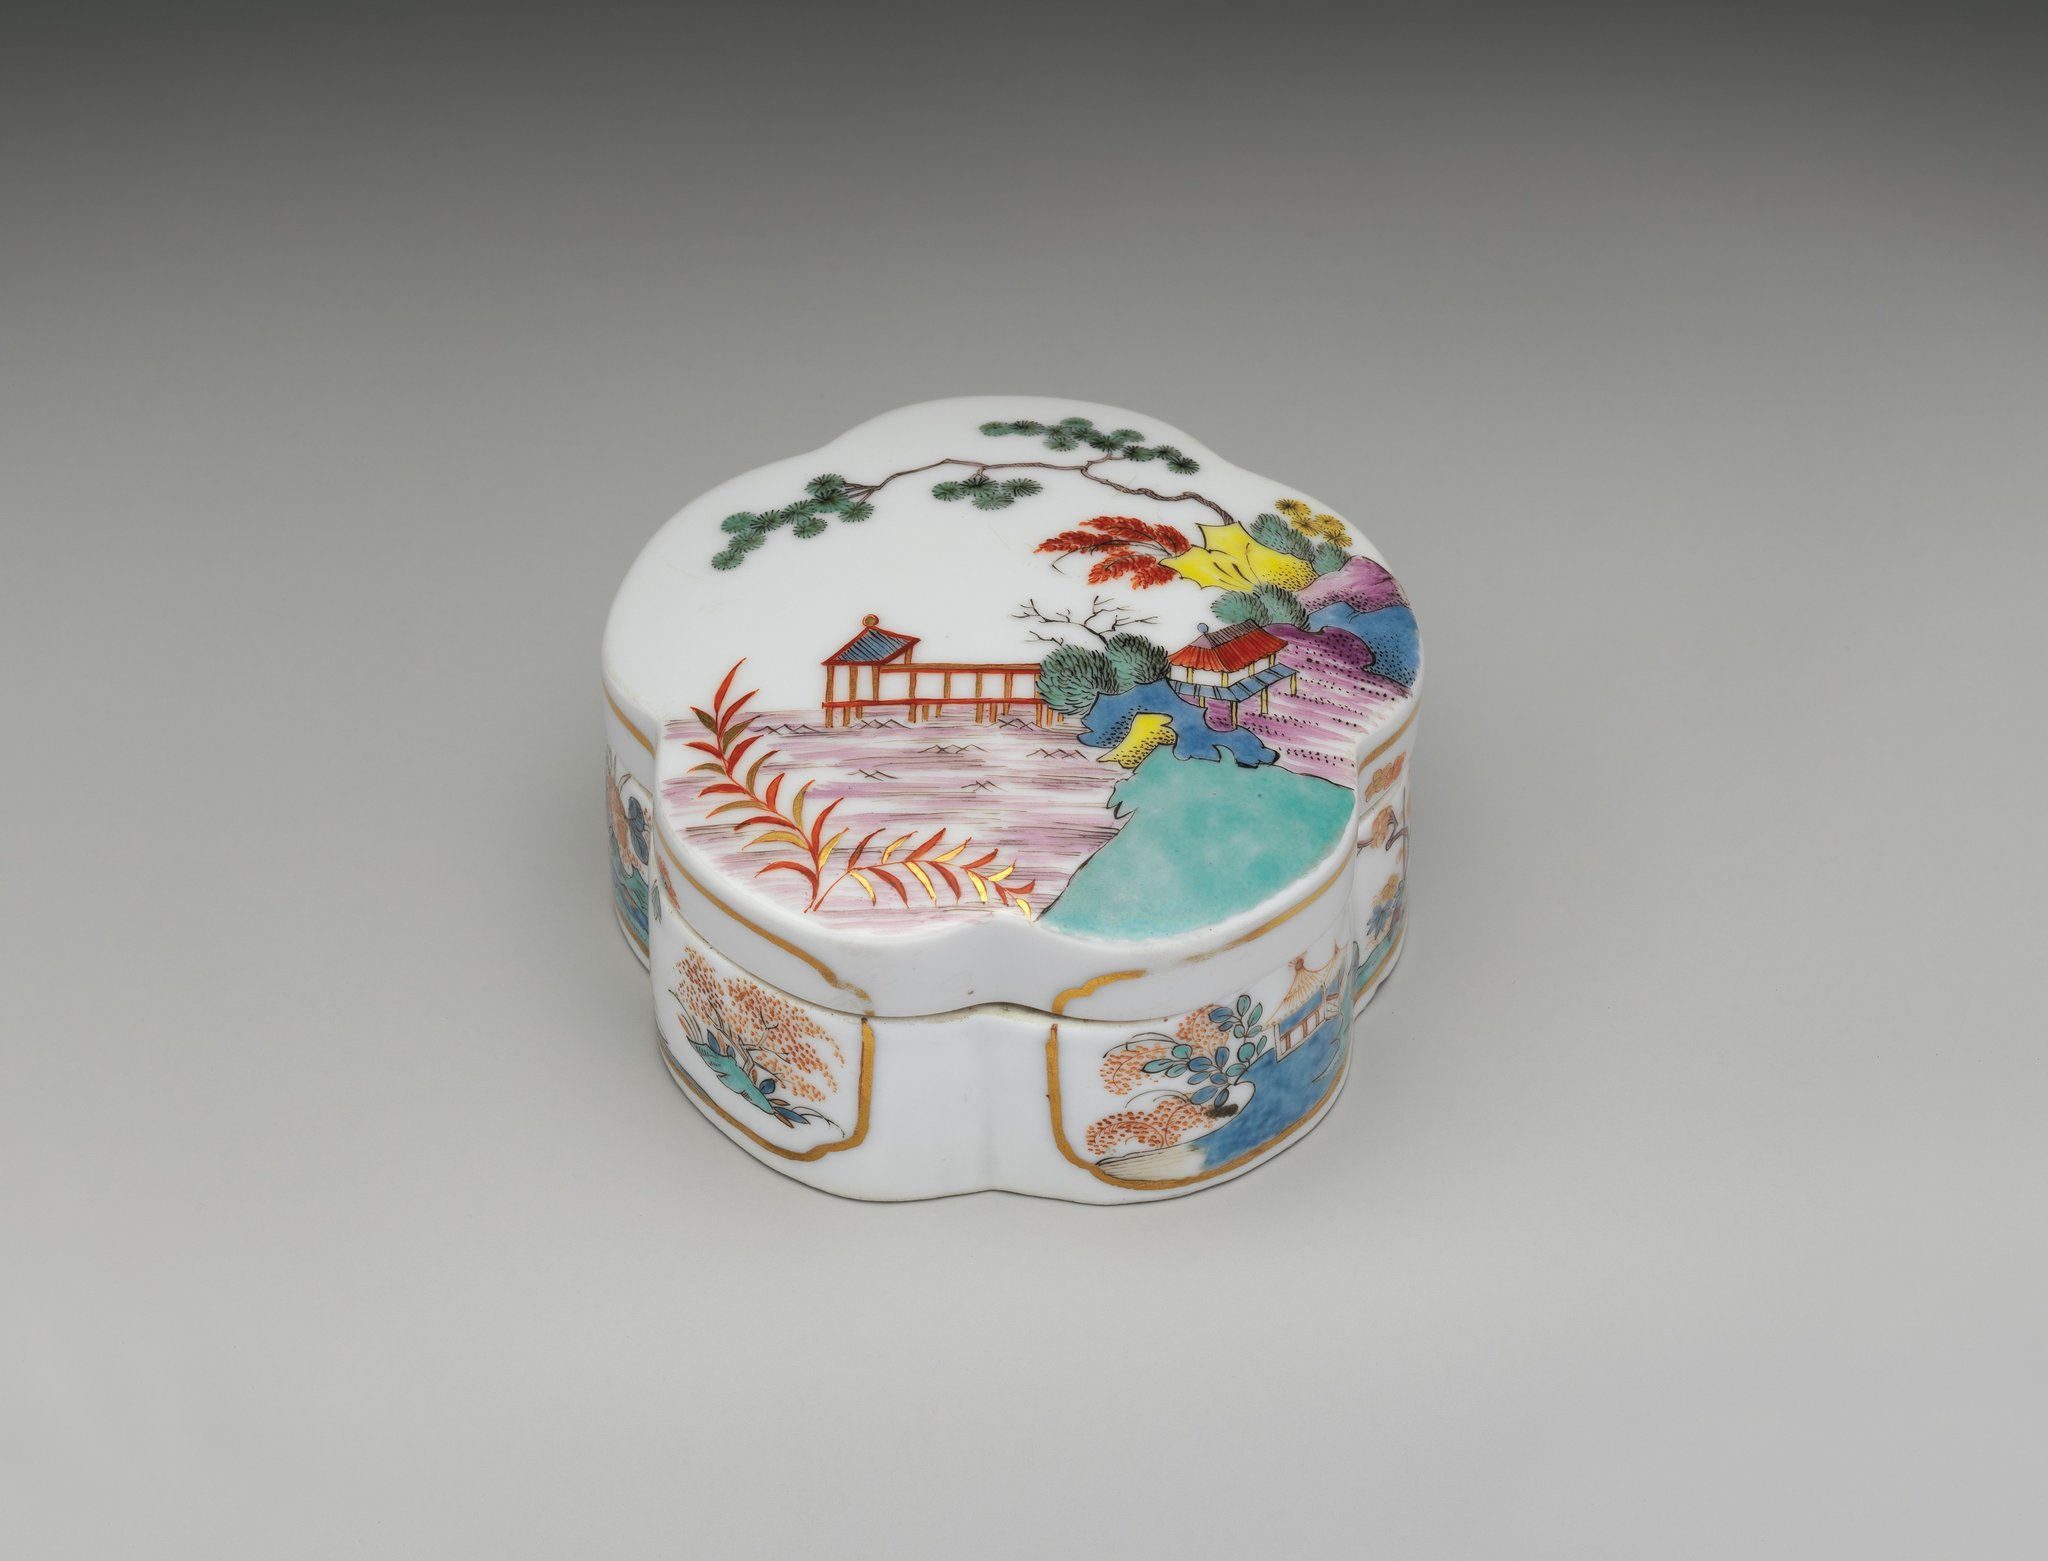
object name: box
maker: meissen manufactory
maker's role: manufactory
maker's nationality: german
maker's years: 1710-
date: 1730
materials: hard paste porcelain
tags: trees